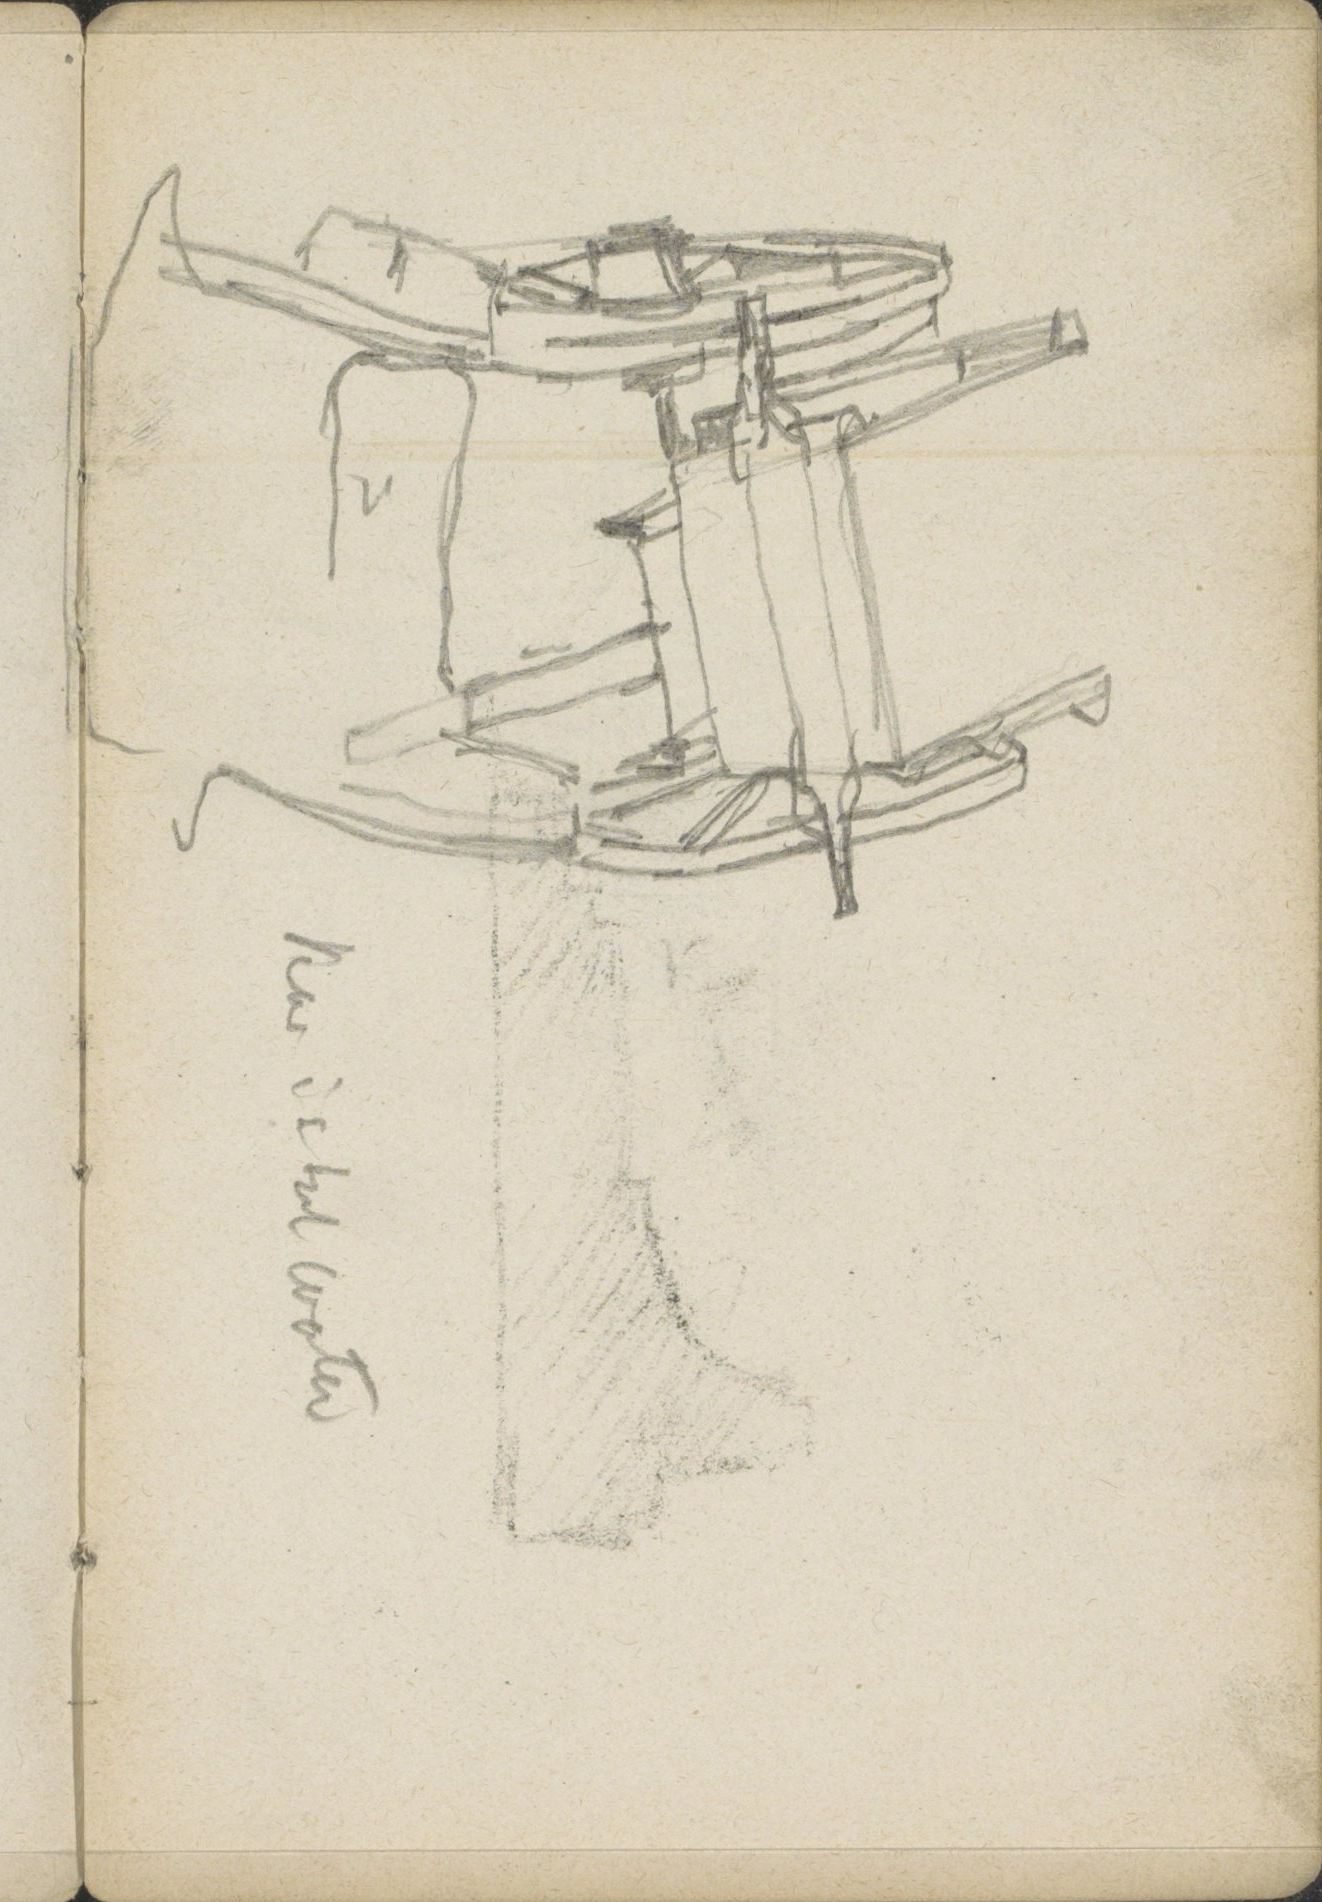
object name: sketchbook leaf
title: Handkar in het water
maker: george hendrik breitner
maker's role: draughtsman, painter, print maker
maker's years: 1857-1923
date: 1900-1901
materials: paper, pencil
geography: amsterdam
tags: hand-cart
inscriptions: annotation: ‘Kar in het water’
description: Handkar in het water. Pagina 76 uit een schetsboek met 46 bladen vervaardigd te Amsterdam.